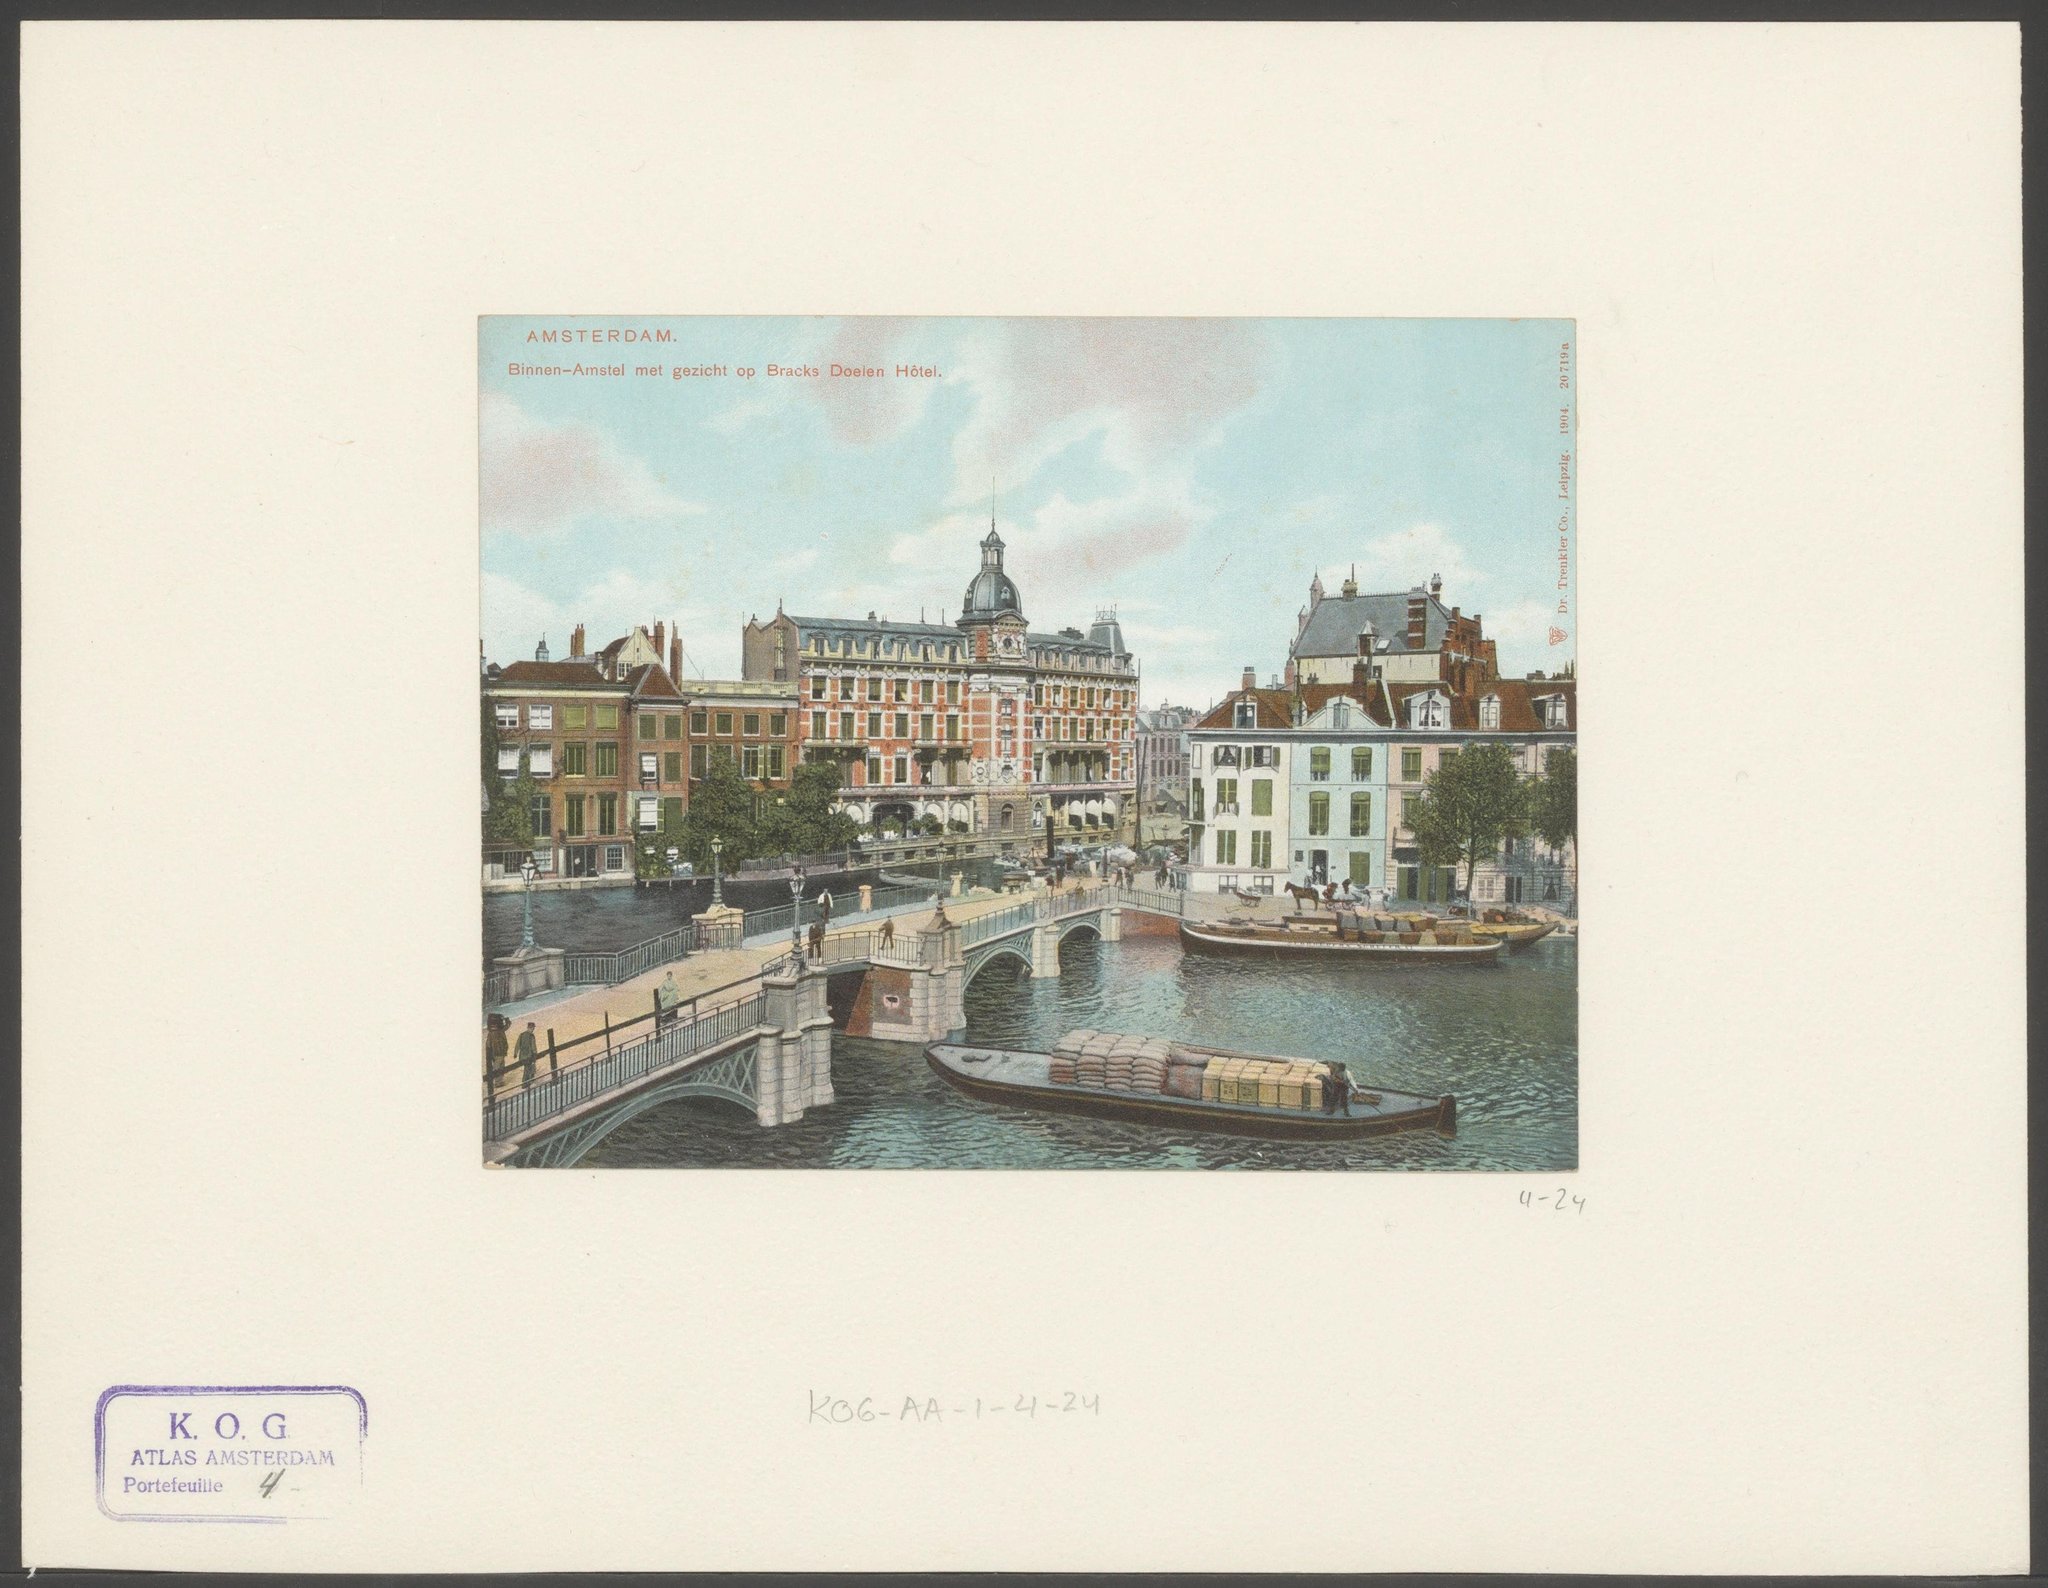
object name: photomechanical print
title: Gezicht op de Halvemaansbrug en het Doelenhotel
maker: Anonymous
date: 1904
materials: cardboard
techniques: autotype, color autotype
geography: leipzig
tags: city-view in general; 'veduta', canal, bridge in city across river, canal, etc., hotel, hostelry, inn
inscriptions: collector's mark: ‘4’ Lugt 1641b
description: Onderwerpsrubriek binnen de Atlas Amsterdam: Amstel van Doelensluis tot Blauwbrug.